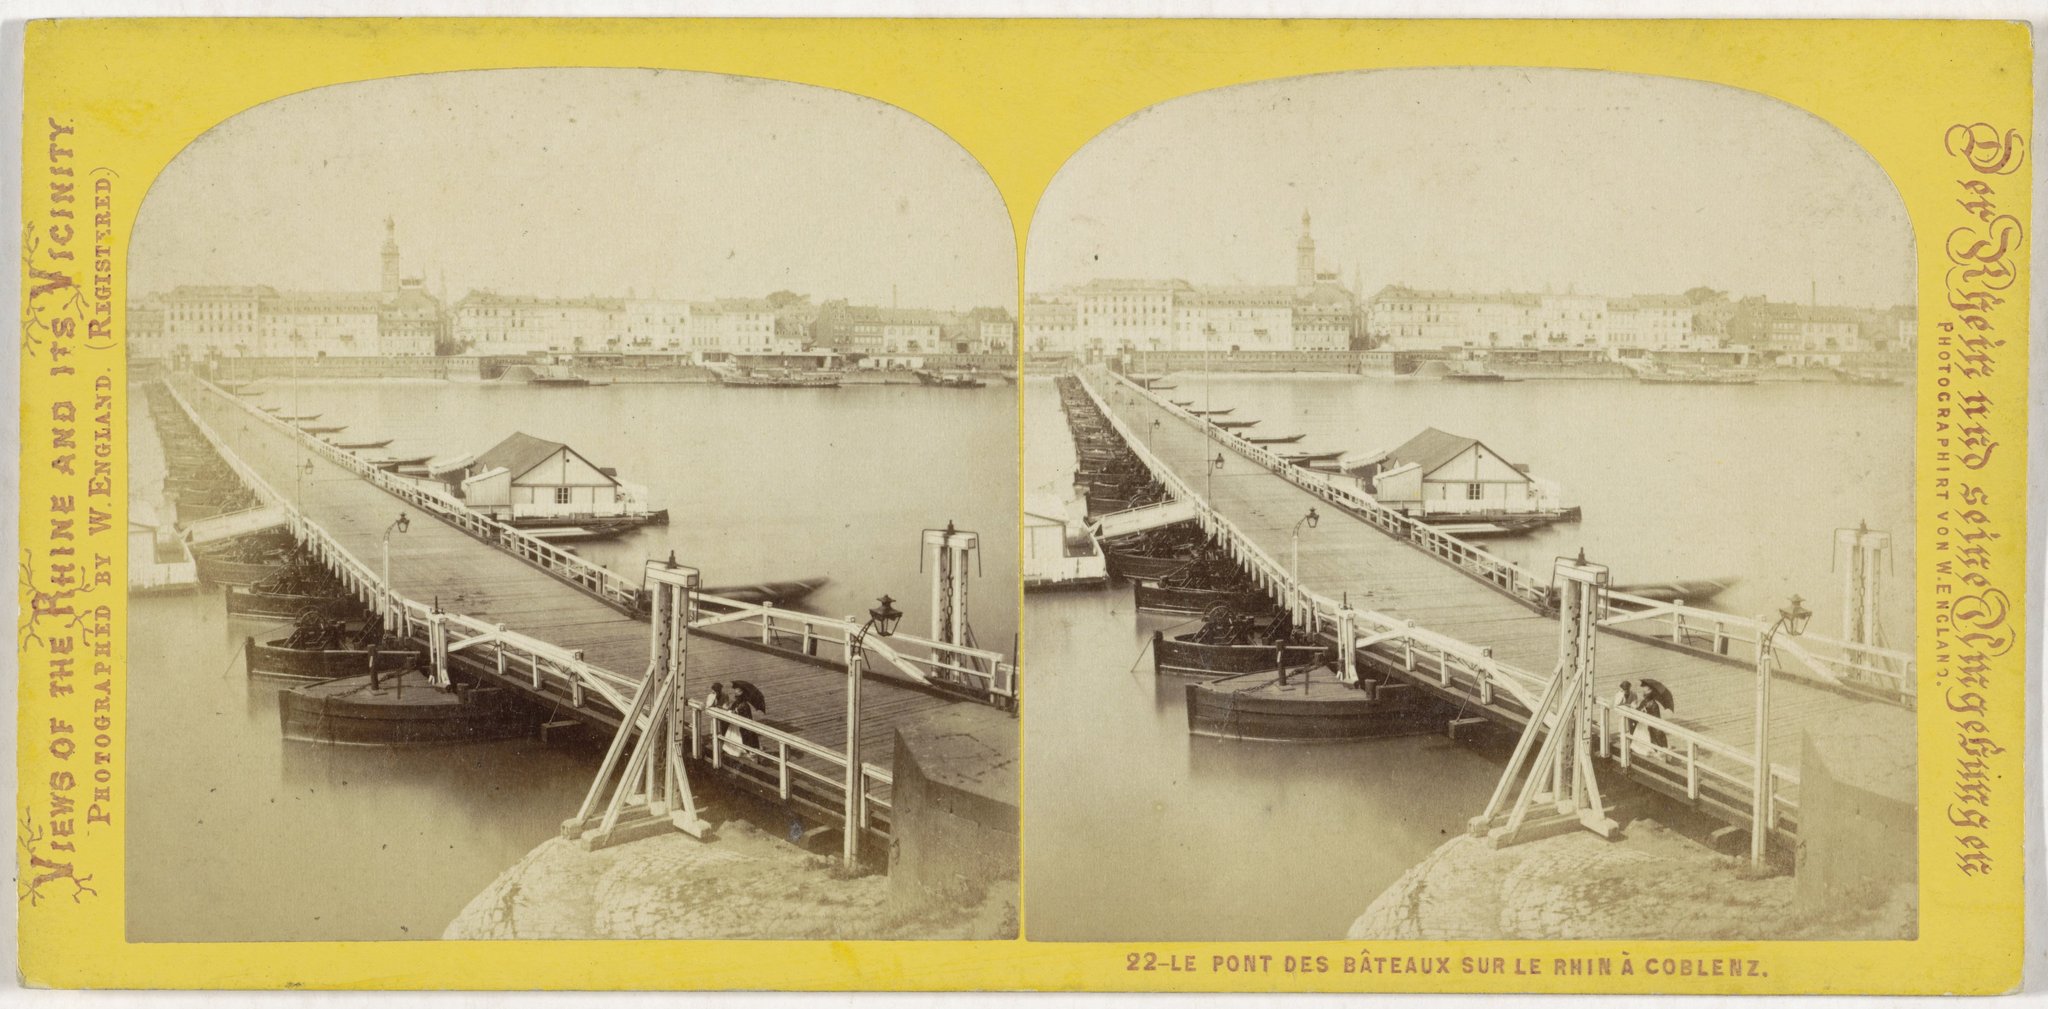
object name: stereograph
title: Le pont des bâteaux sur le Rhin à Coblenz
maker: william england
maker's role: fotograaf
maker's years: 1816-1896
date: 1867-1868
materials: cardboard, paper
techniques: albumen print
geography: koblenz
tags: river, pontoon bridge, prospect of city, town panorama, silhouette of city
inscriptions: inscription: ‘(Registered)’, number: ‘22’